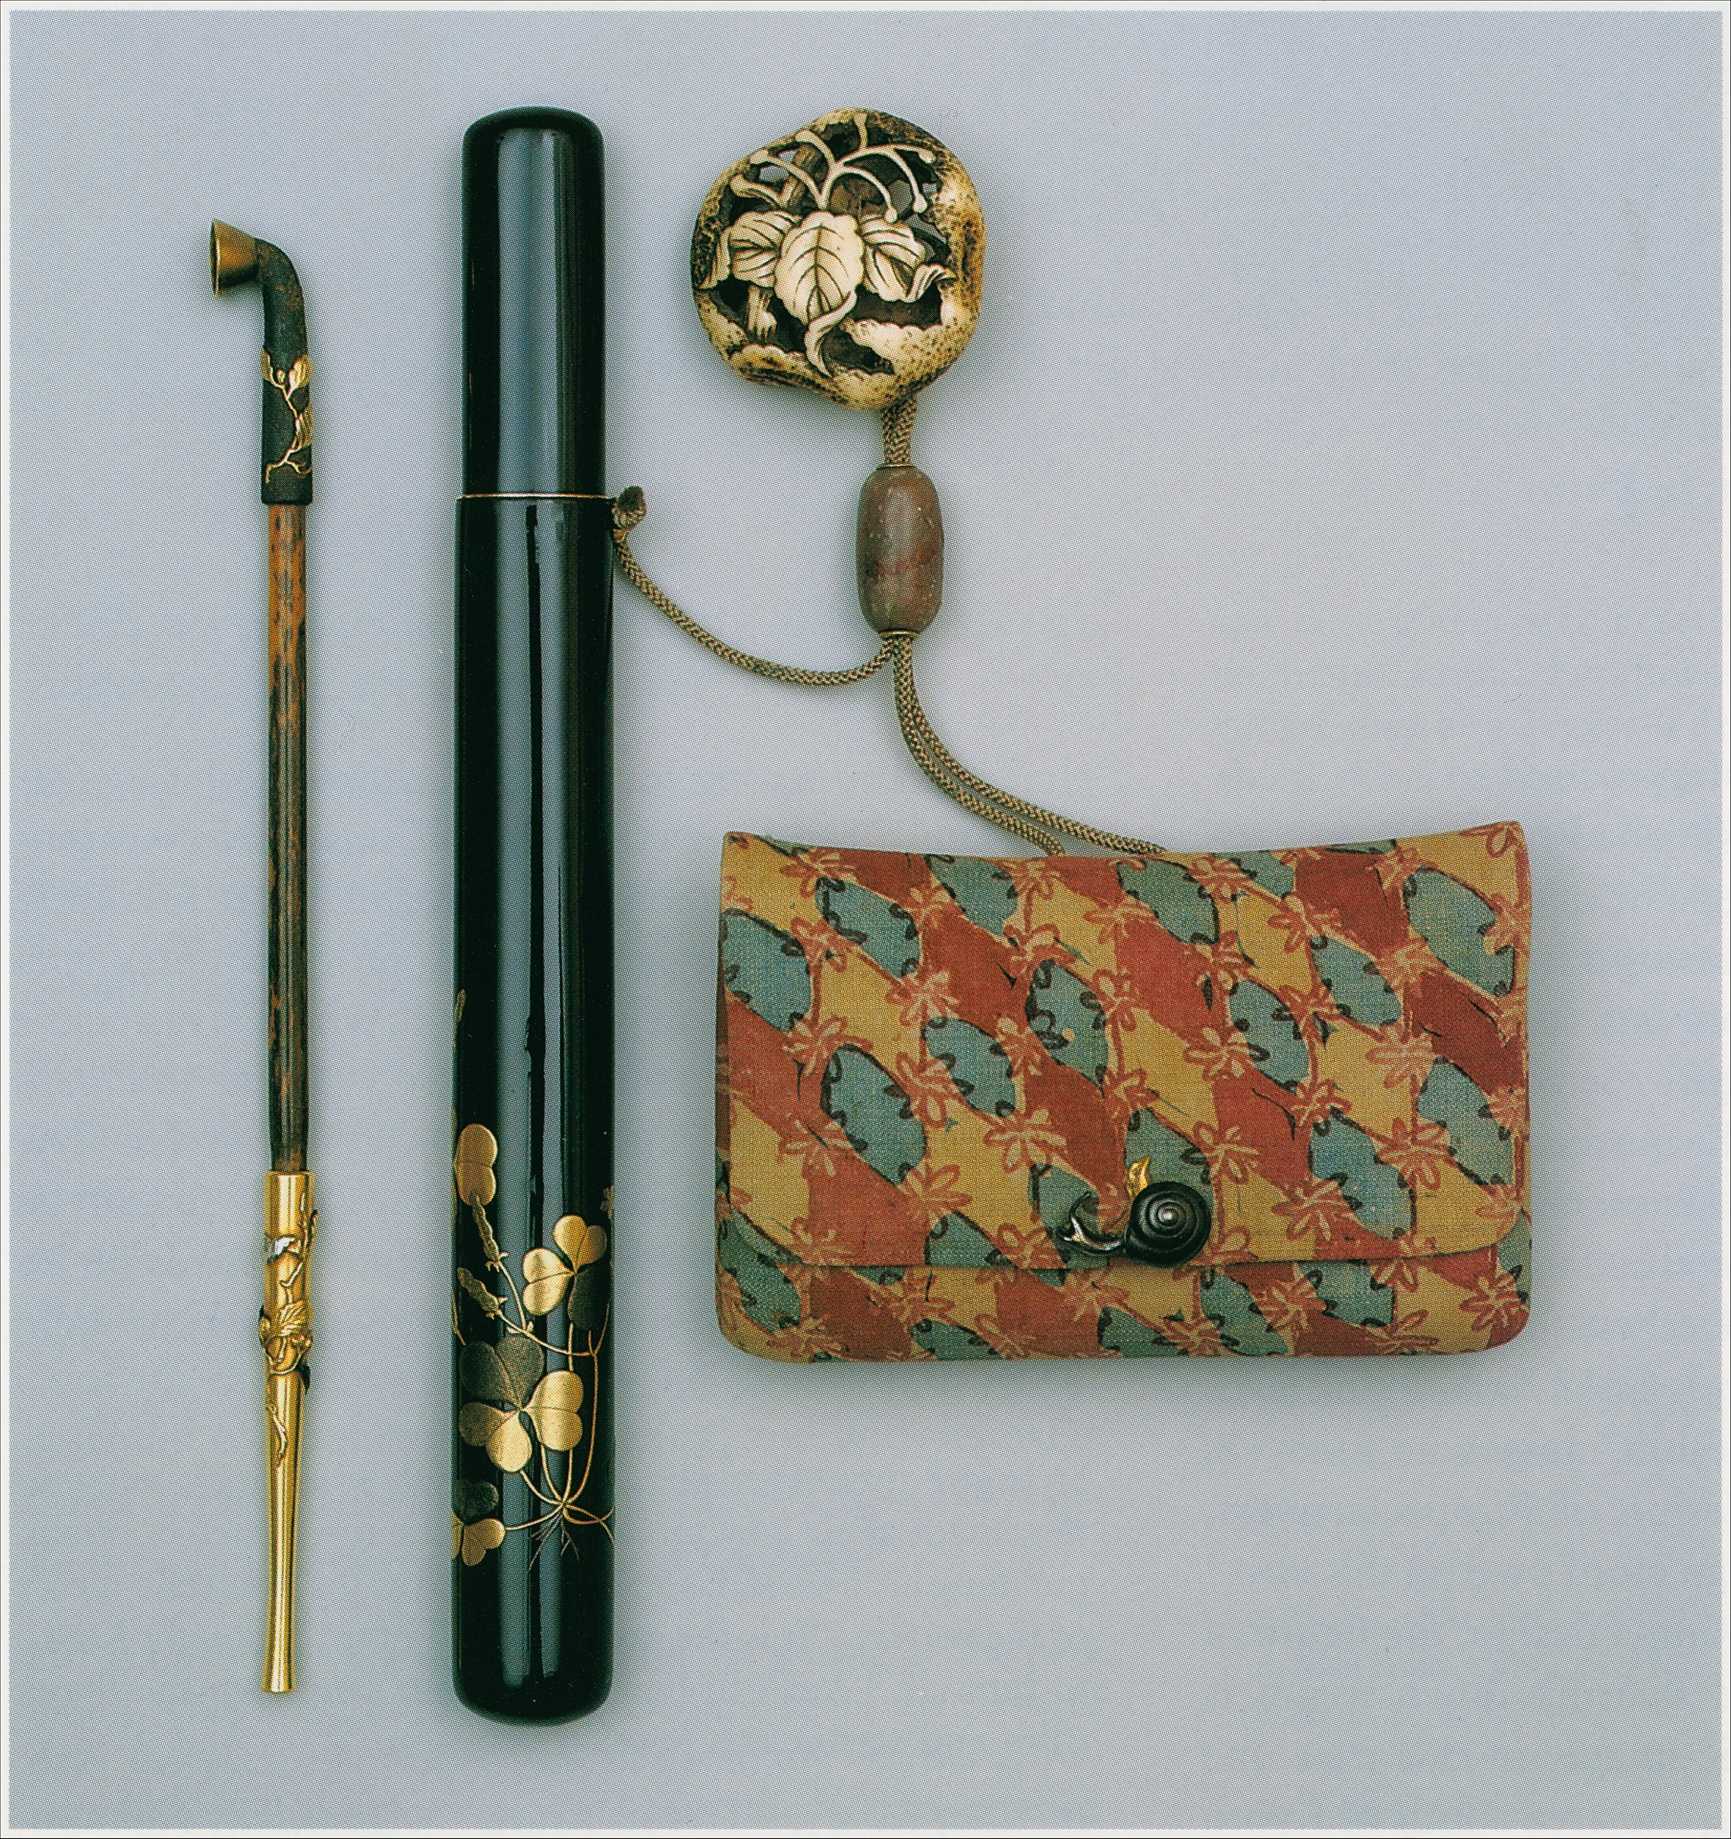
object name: smoking set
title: Pipe and Pipe Case with Tobacco Pouch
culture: japanese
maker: shibata zeshin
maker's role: artist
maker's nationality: japanese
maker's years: 1807-1891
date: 1801-1833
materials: cotton, gold, iron, lacquer, metal, silver, wood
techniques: carving, dyeing, hiramakie